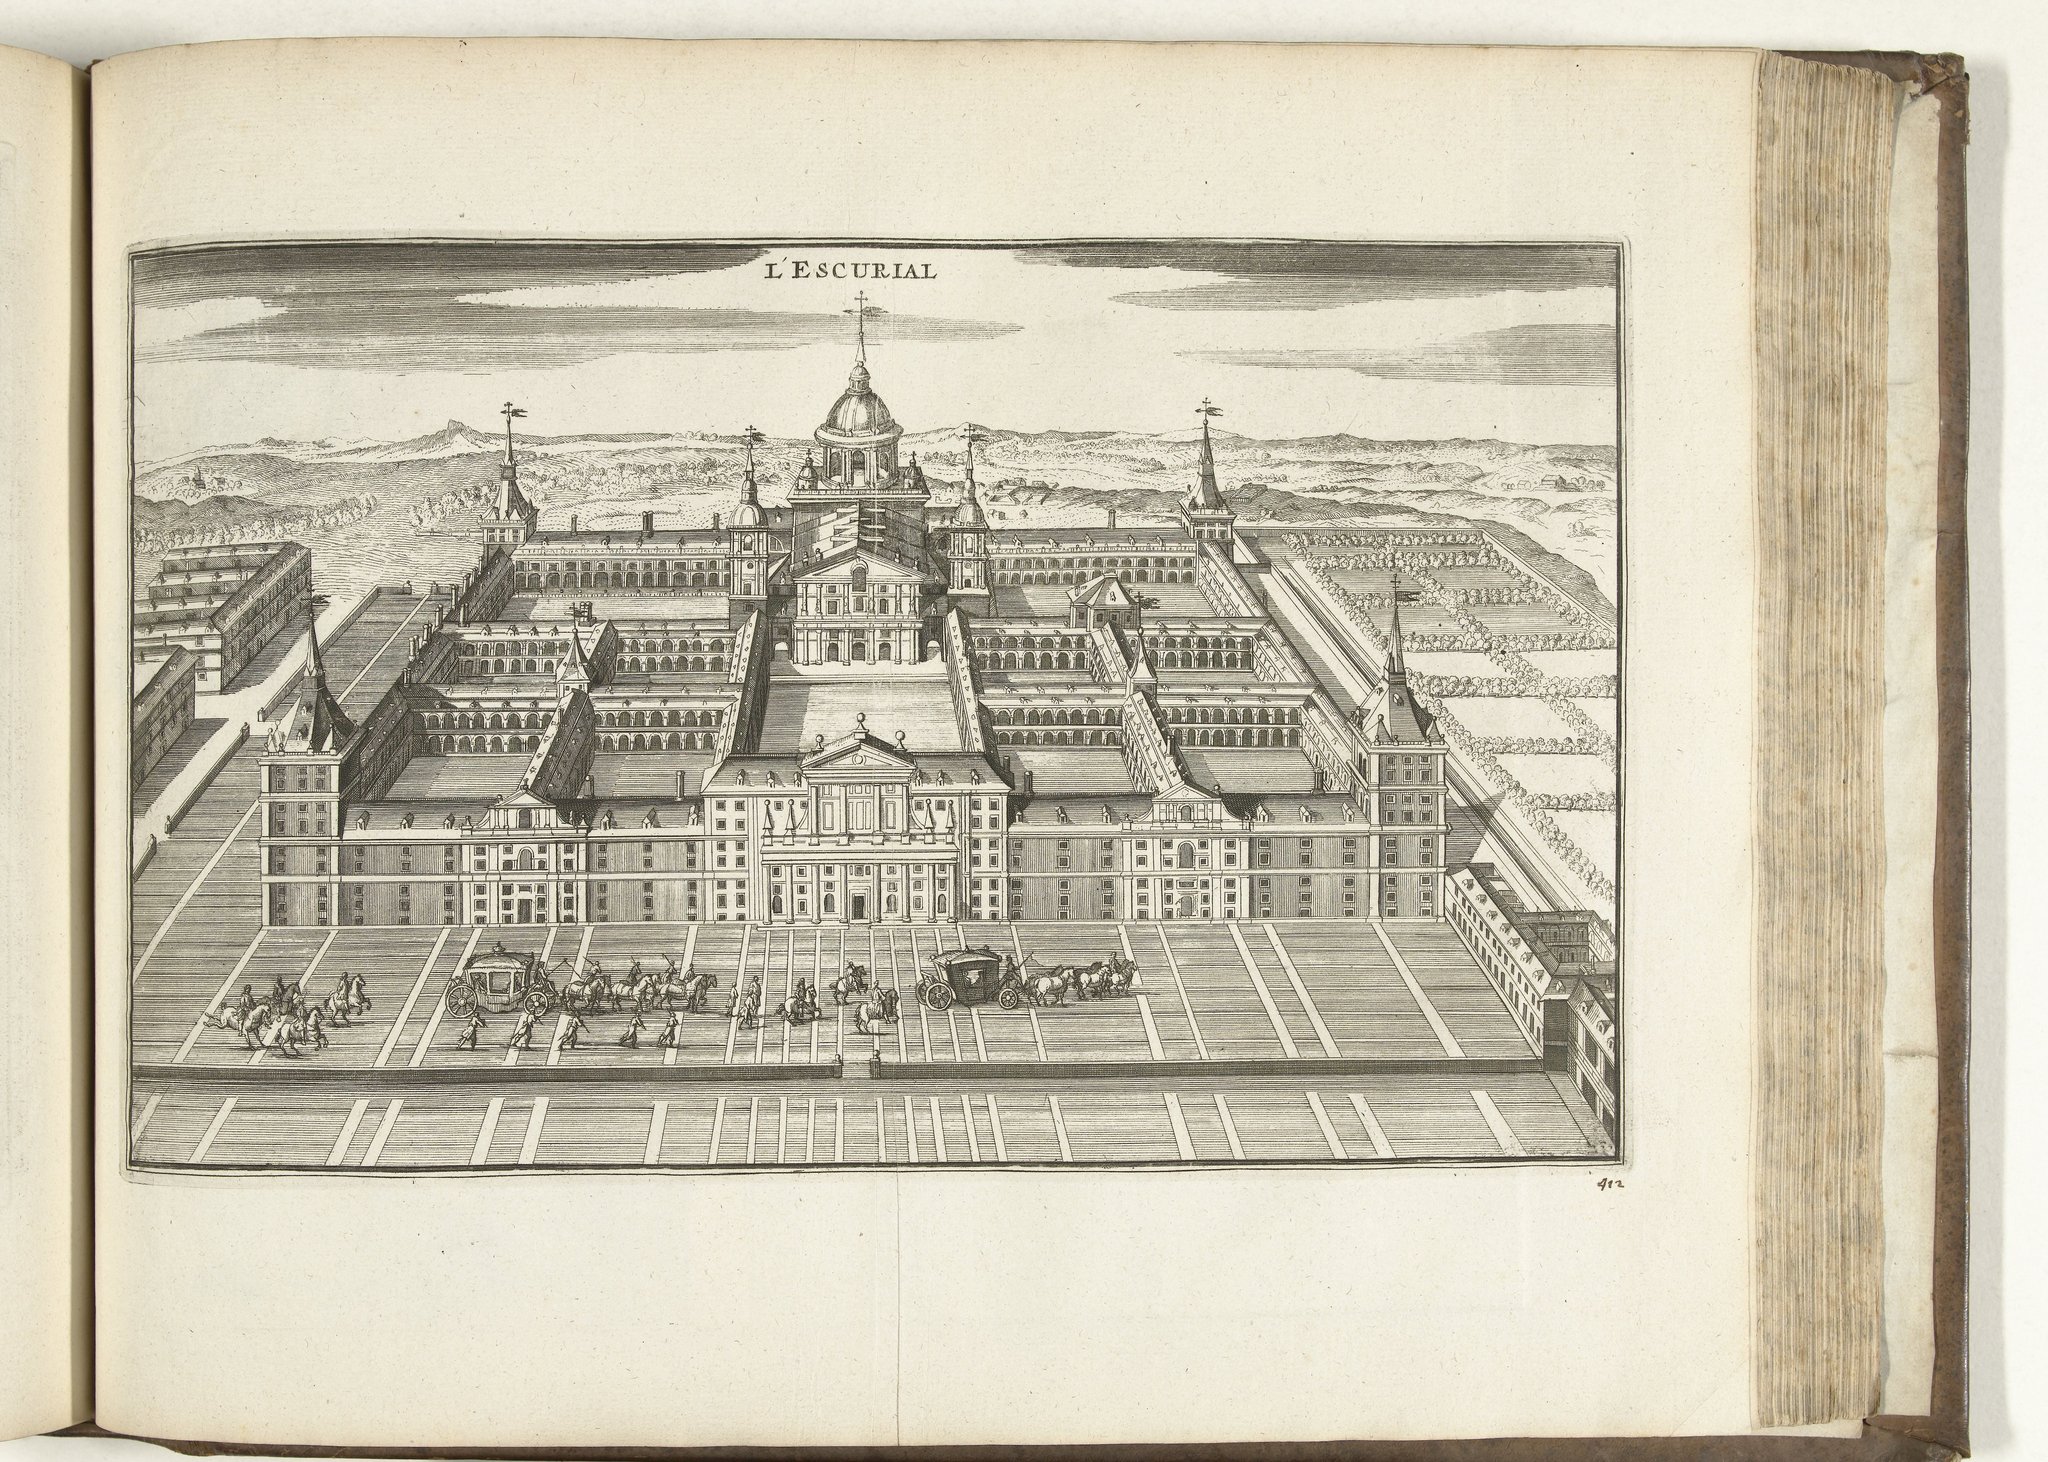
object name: print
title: Les Forces de l'Europe, Asie, Afrique et Amerique (...) Comme aussi les Cartes des Côtes de France et d'Espagne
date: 1726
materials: paper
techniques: etching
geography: northern netherlands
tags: palace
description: Gezicht op het Escorial. Plaat nr. 412 in deel XVII van het prentwerk: Les Forces de l'Europe, Asie, Afrique et Amerique ... Comme aussi les Cartes des Côtes de France et d'Espagne uit 1726, dit tweede deel met 271 met de hand genummerde platen van vermaarde sterke steden en vestingen in het kader van de Spaanse Successieoorlog 1701-1713. Voor het merendeel zijn deze platen gekopieerd naar de anonieme Franse platen van vermaarde sterke steden en vestingen: in Les forces de l'Europe en in: Le theatre de la guerre, dans les Pays-Bas, beide oorspronkelijk uitgegeven door Nicolas de Fer te Parijs (1693-1697) in het kader van de Negenjarige Oorlog. Rechtsonder sporen van het weggepolijste nummer: (260?).